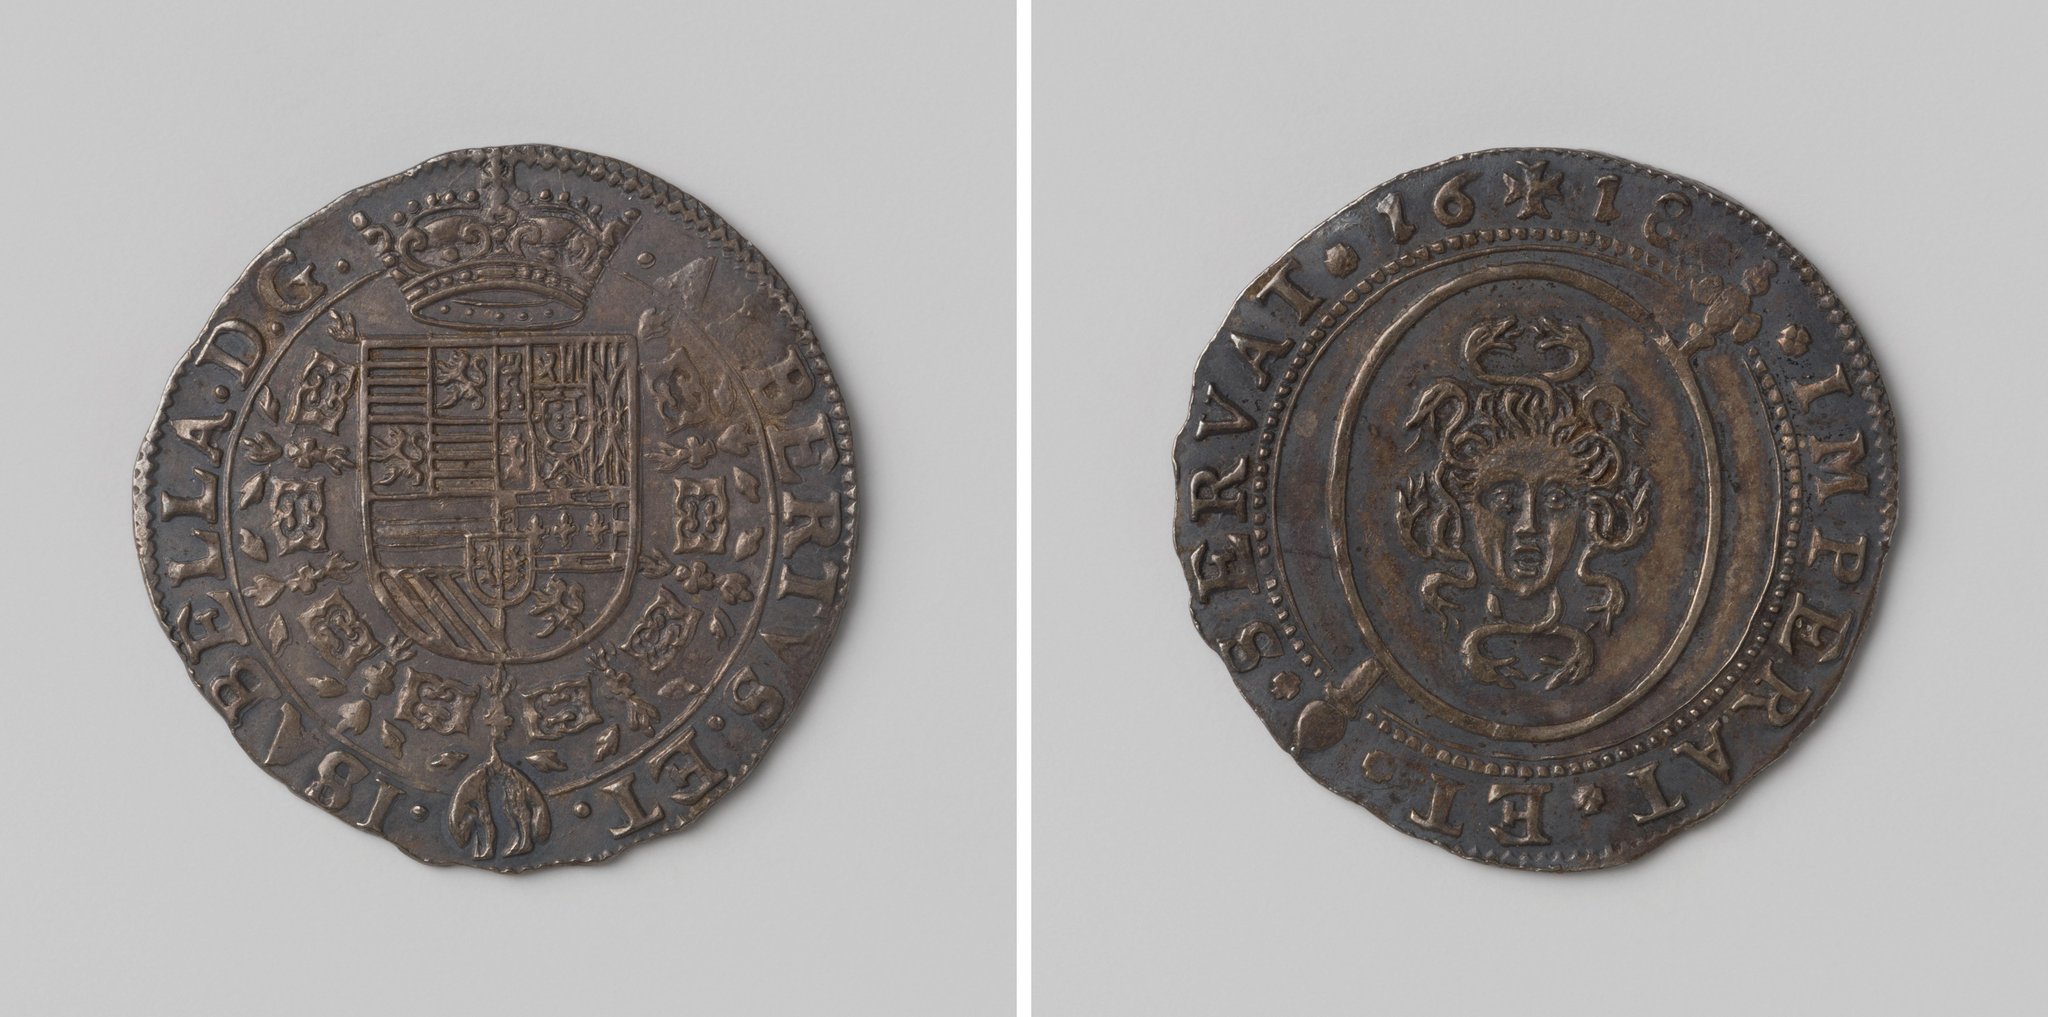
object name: jeton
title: Albrecht en Isabella van Oostenrijk, vorsten van de zuidelijke Nederlanden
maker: Anonymous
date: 1618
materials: silver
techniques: striking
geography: belgium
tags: infante van spanje isabella clara eugenia, brussels, albrecht aartshertog van oostenrijk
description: Zilveren penning. Voorzijde: gekroond wapenschild, omhangen met de orde van het Gulden Vlies binnen omschrift. Keerzijde: schild met afbeelding van kop van Medusa, voor scepter binnen omschrift